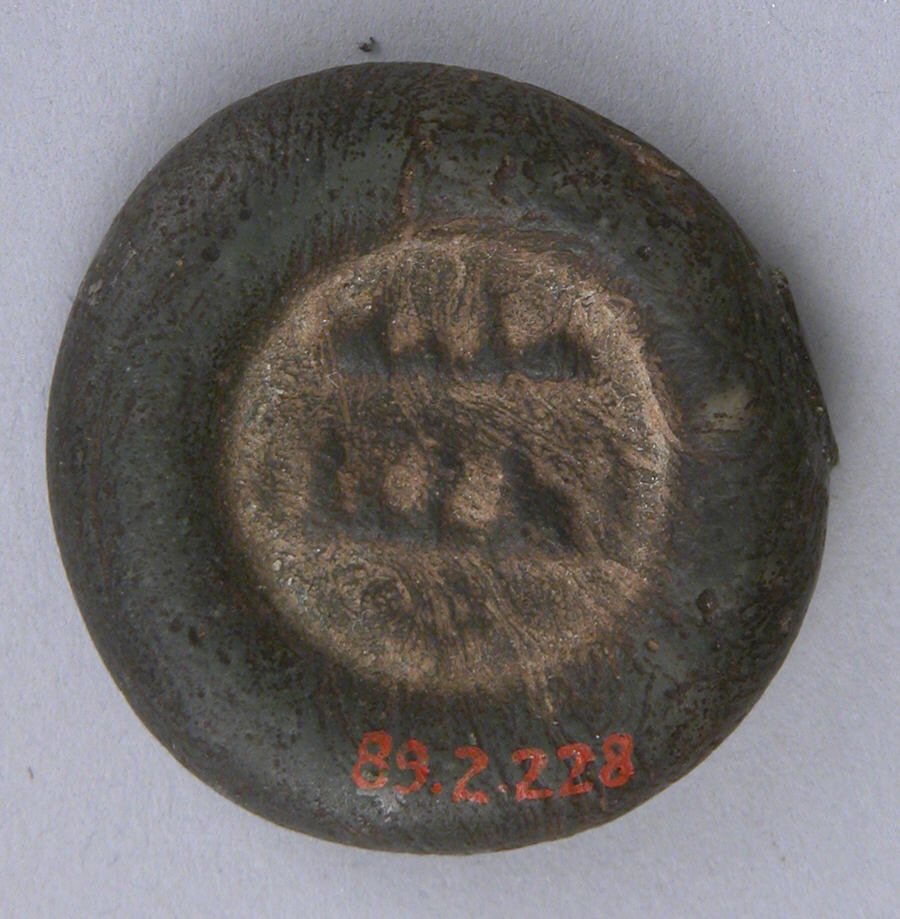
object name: coin weight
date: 1201-1400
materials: glass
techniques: stamping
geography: egypt